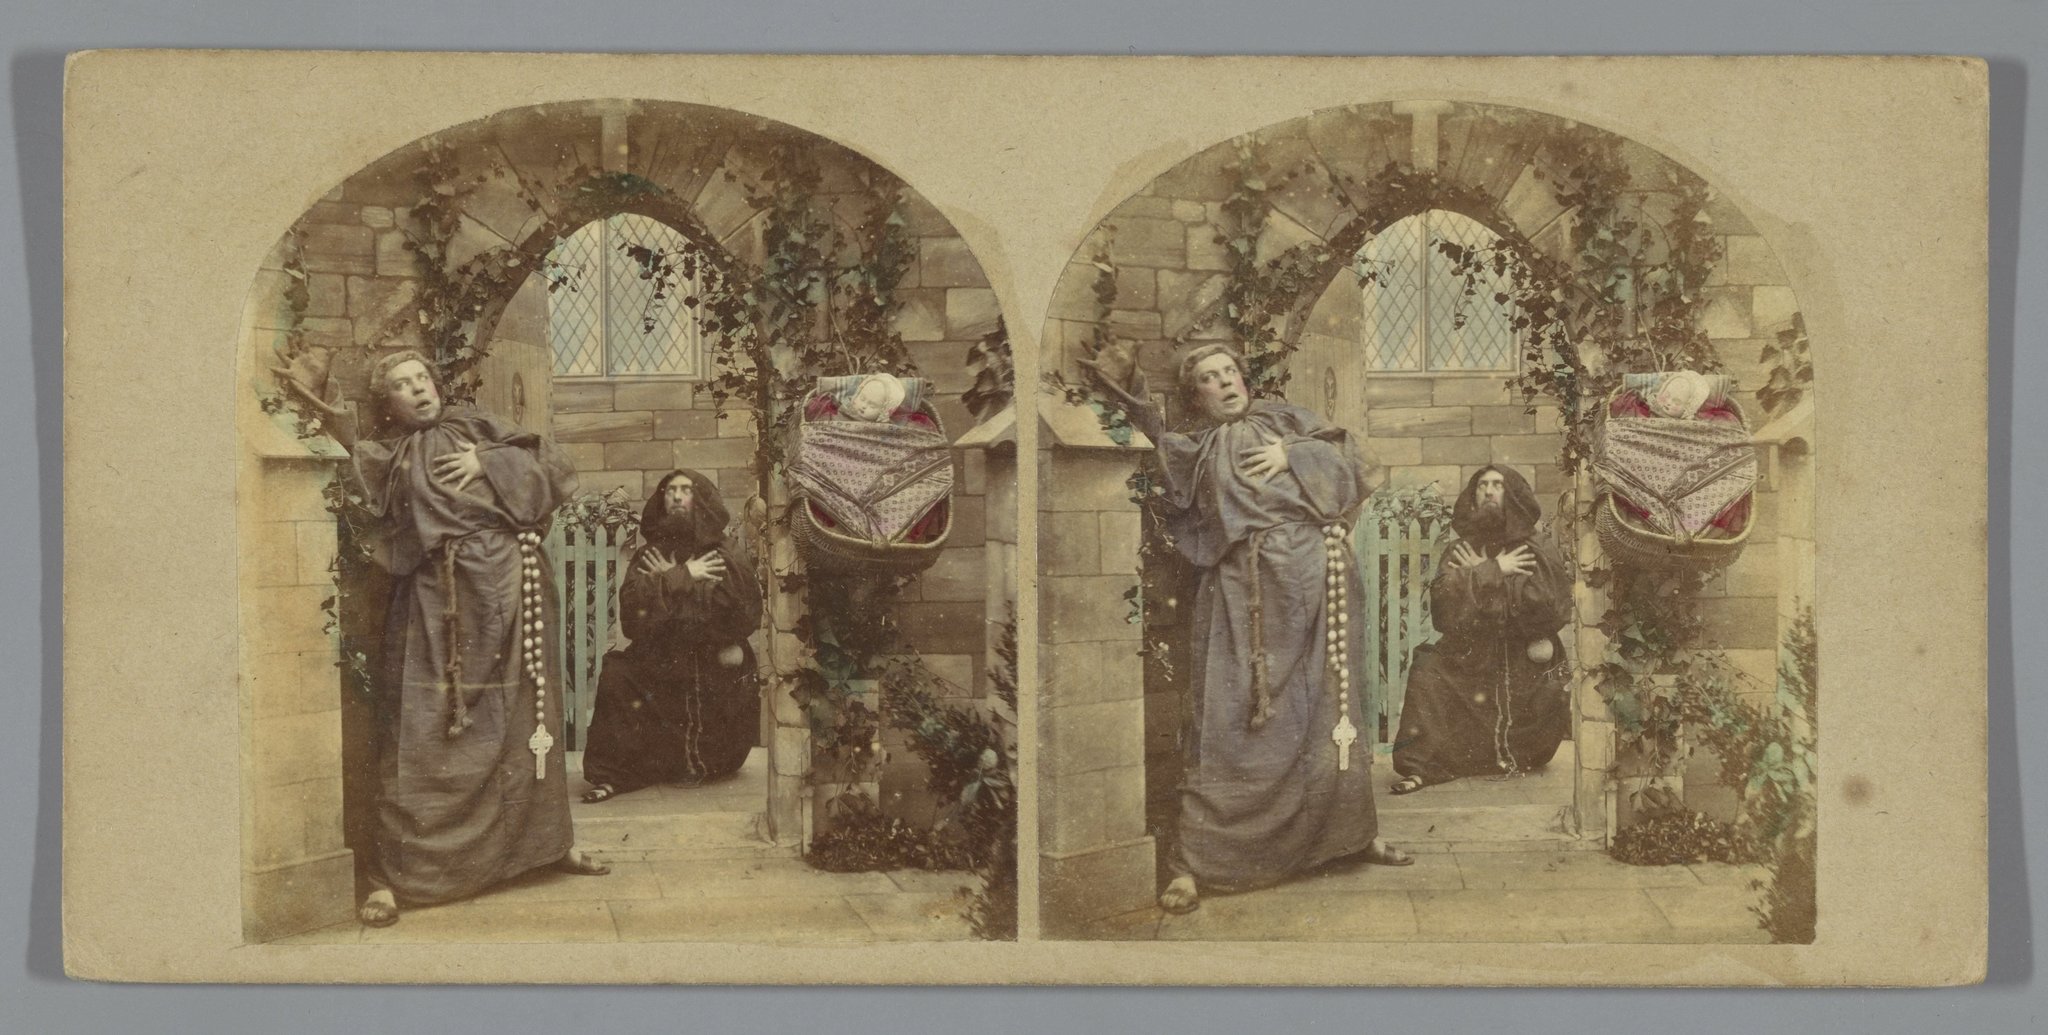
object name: stereograph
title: Twee monniken en een vondeling bij een klooster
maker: Anonymous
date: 1852-1863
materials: cardboard, paper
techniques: albumen print, hand coloring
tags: finding an exposed child, monk(s), friar(s), cloisters ~ monastery